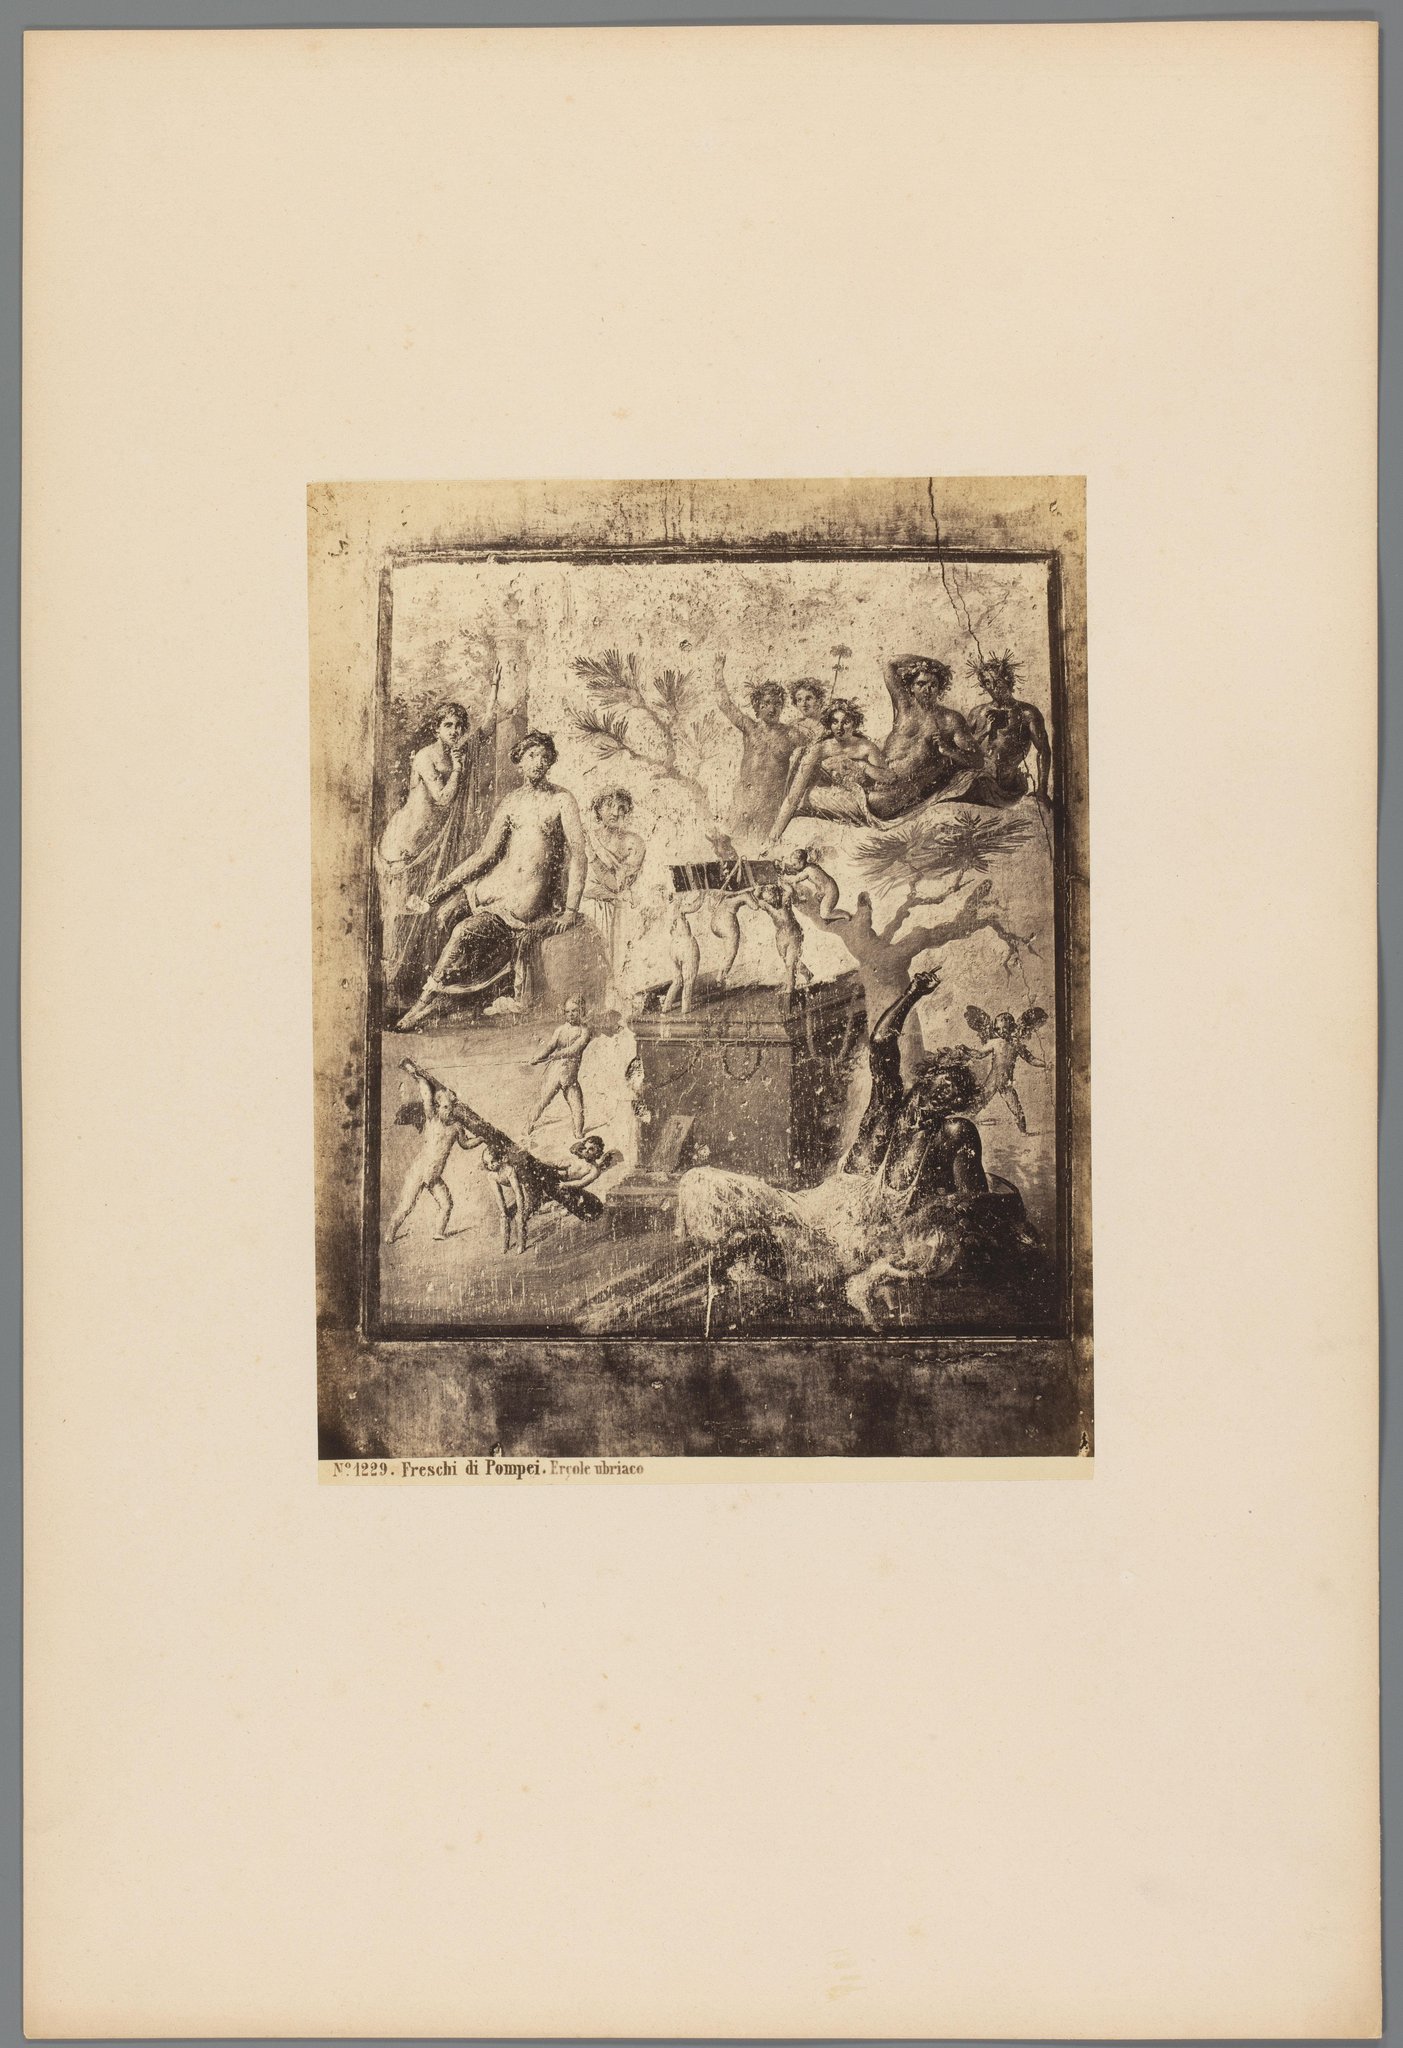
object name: reproduction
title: Fotoreproductie van een fresco van vijf taferelen te Pompeï, Italië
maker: giorgio sommer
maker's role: fotograaf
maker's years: 1834-1914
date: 1857-1900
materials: cardboard, paper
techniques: albumen print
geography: pompeii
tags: wall-covering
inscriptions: number: ‘No. 1229.’